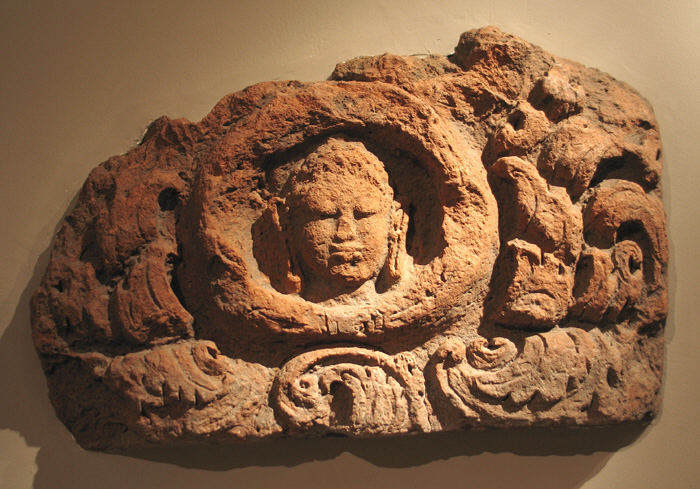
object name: architectural element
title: Architectural Element with Head of a Buddha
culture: indonesian, javanese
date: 801-1000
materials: terracotta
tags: heads,buddhism,buddha